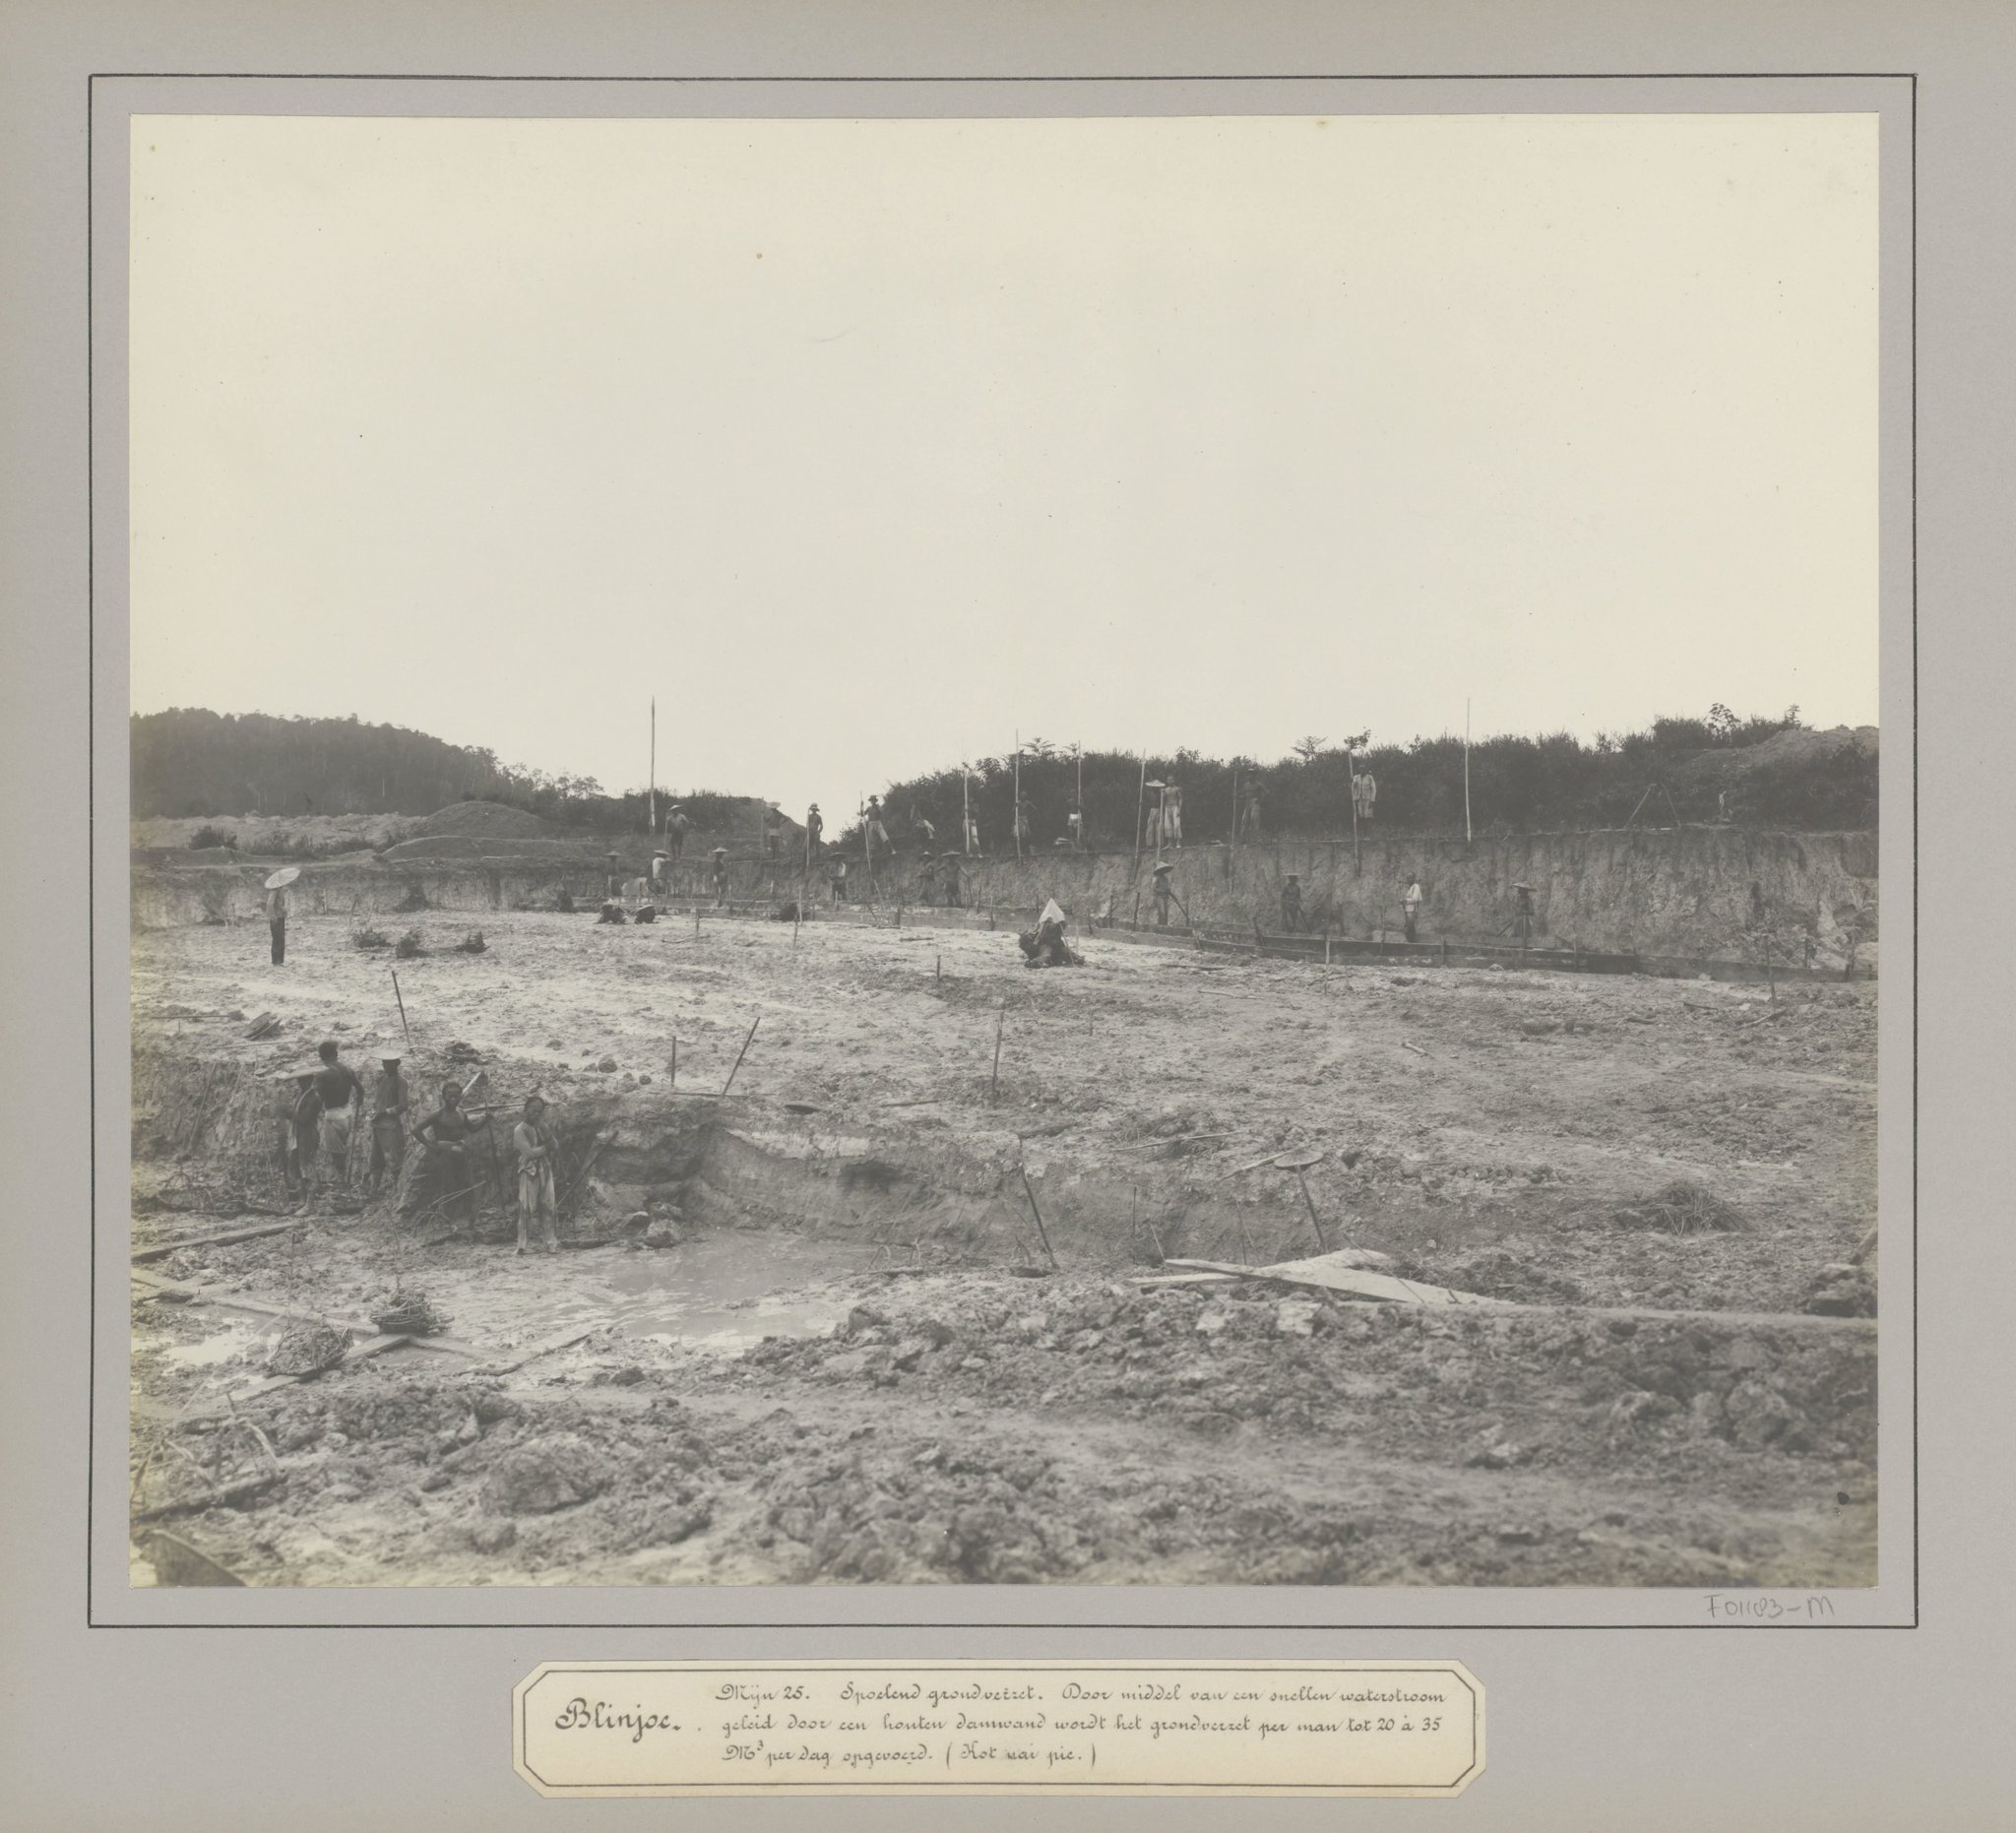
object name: photograph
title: Gezicht op een open tingroeve met arbeiders te Belinyu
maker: Anonymous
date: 1900-1920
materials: photographic support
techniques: gelatin silver print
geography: belinyu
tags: mining, minerals and metals: tin, working class, labourers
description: Mogelijk verwijst de term "Kot nai pic" in het onderschrift naar een fotograaf/fotostudio.